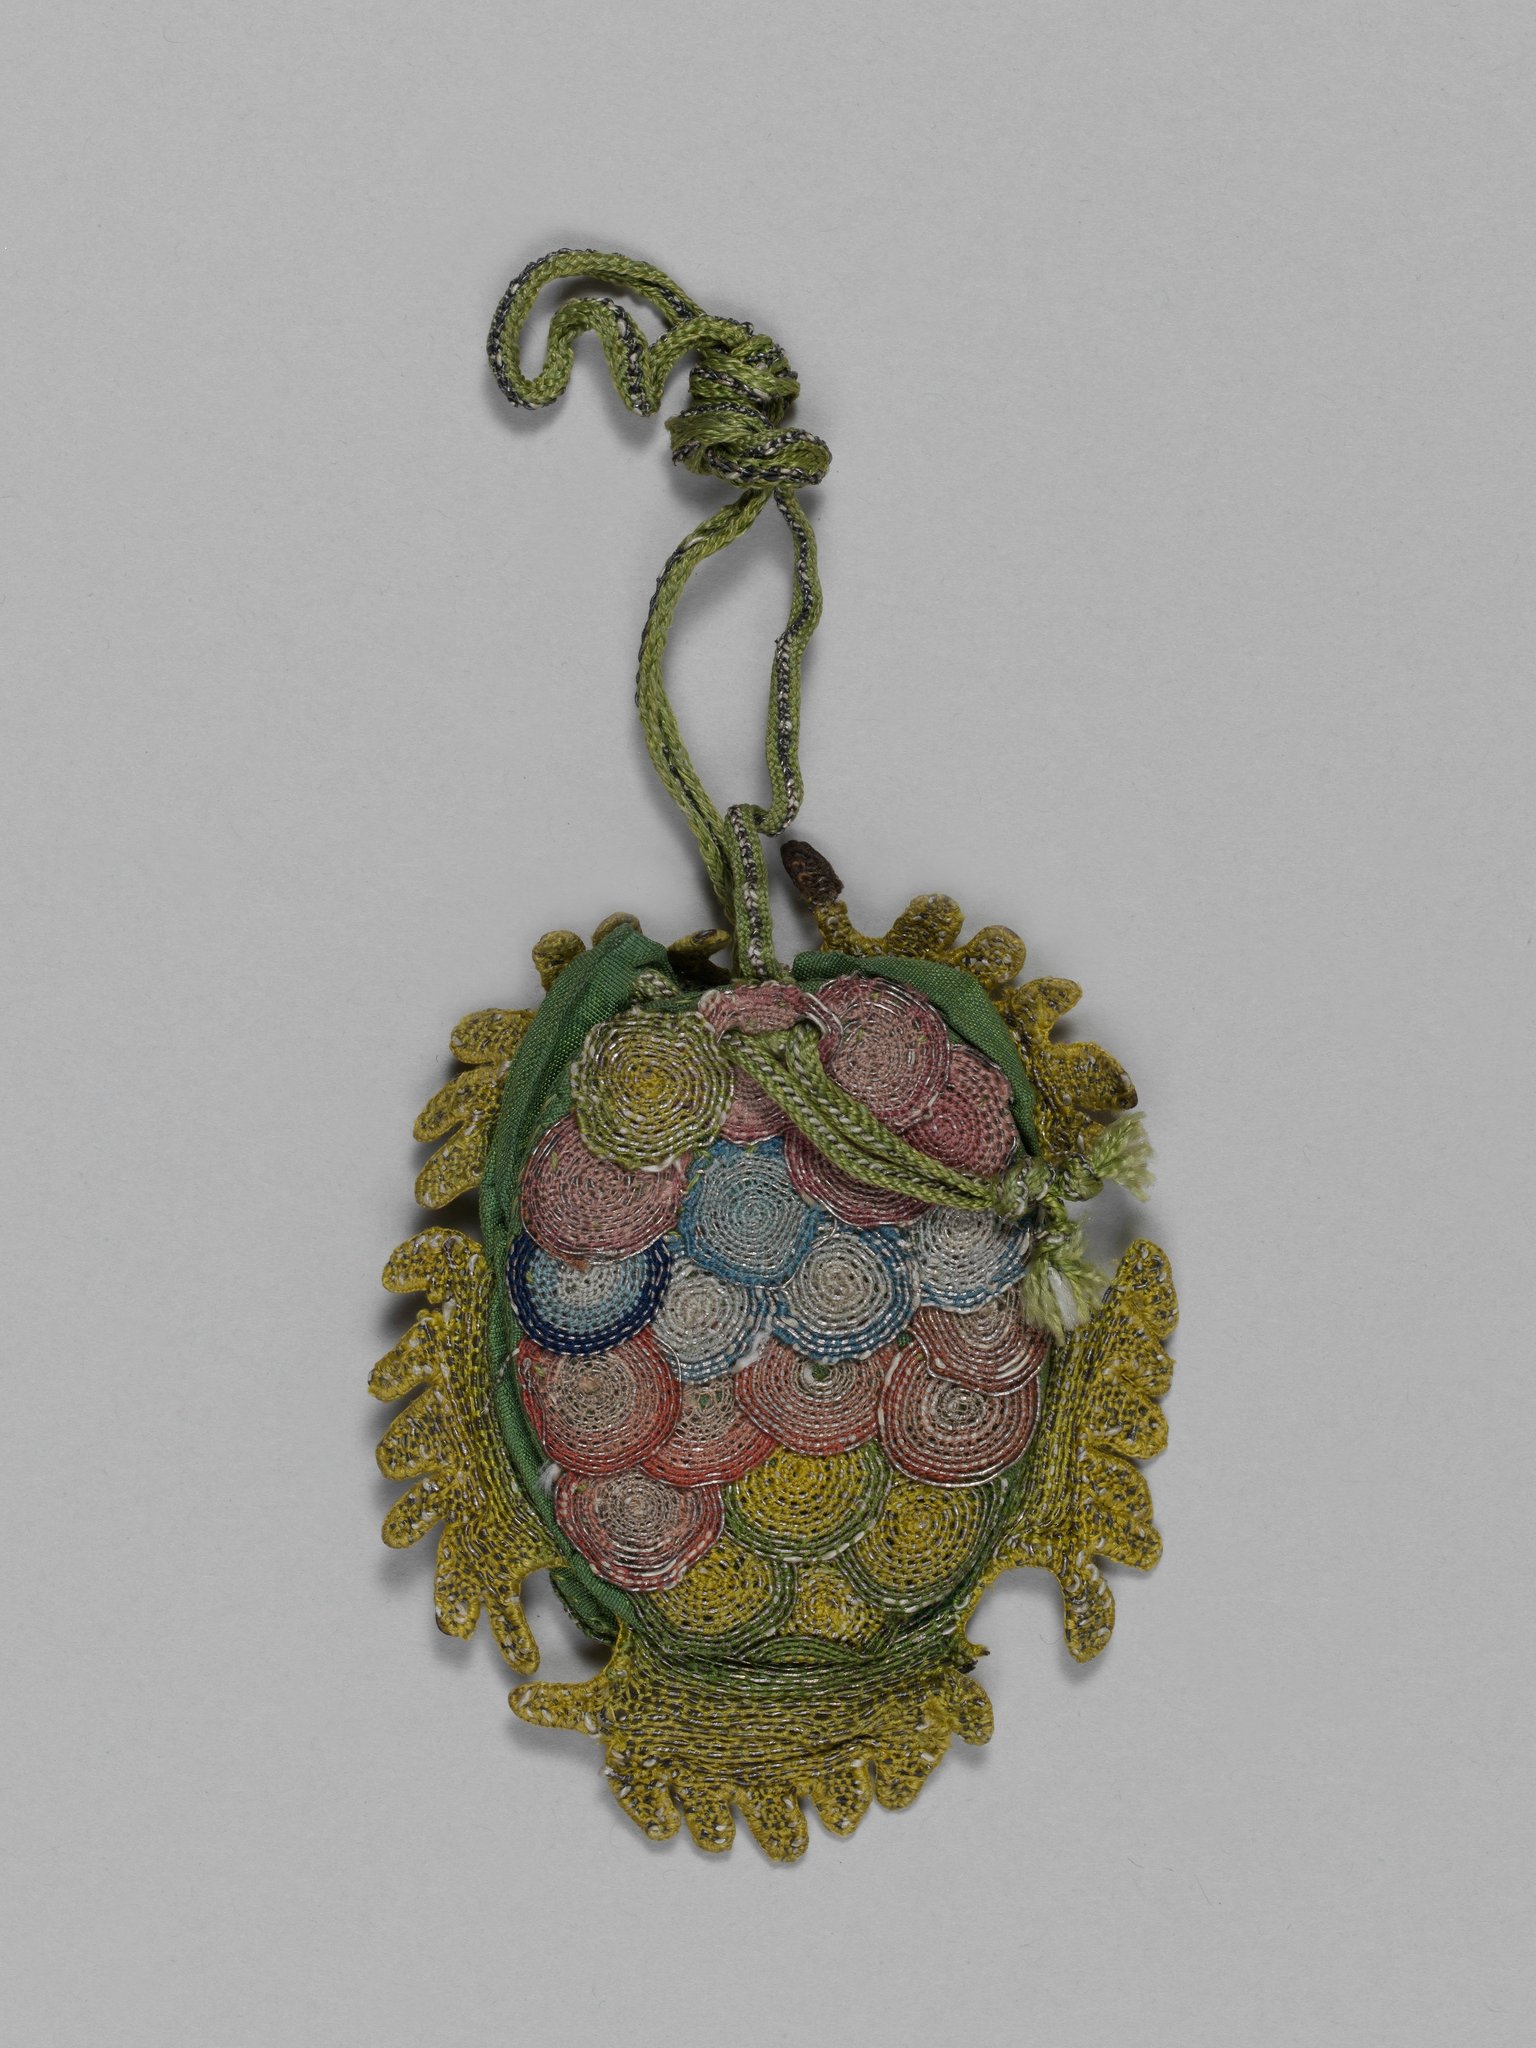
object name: perfume case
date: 1651-1675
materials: metal thread, silk